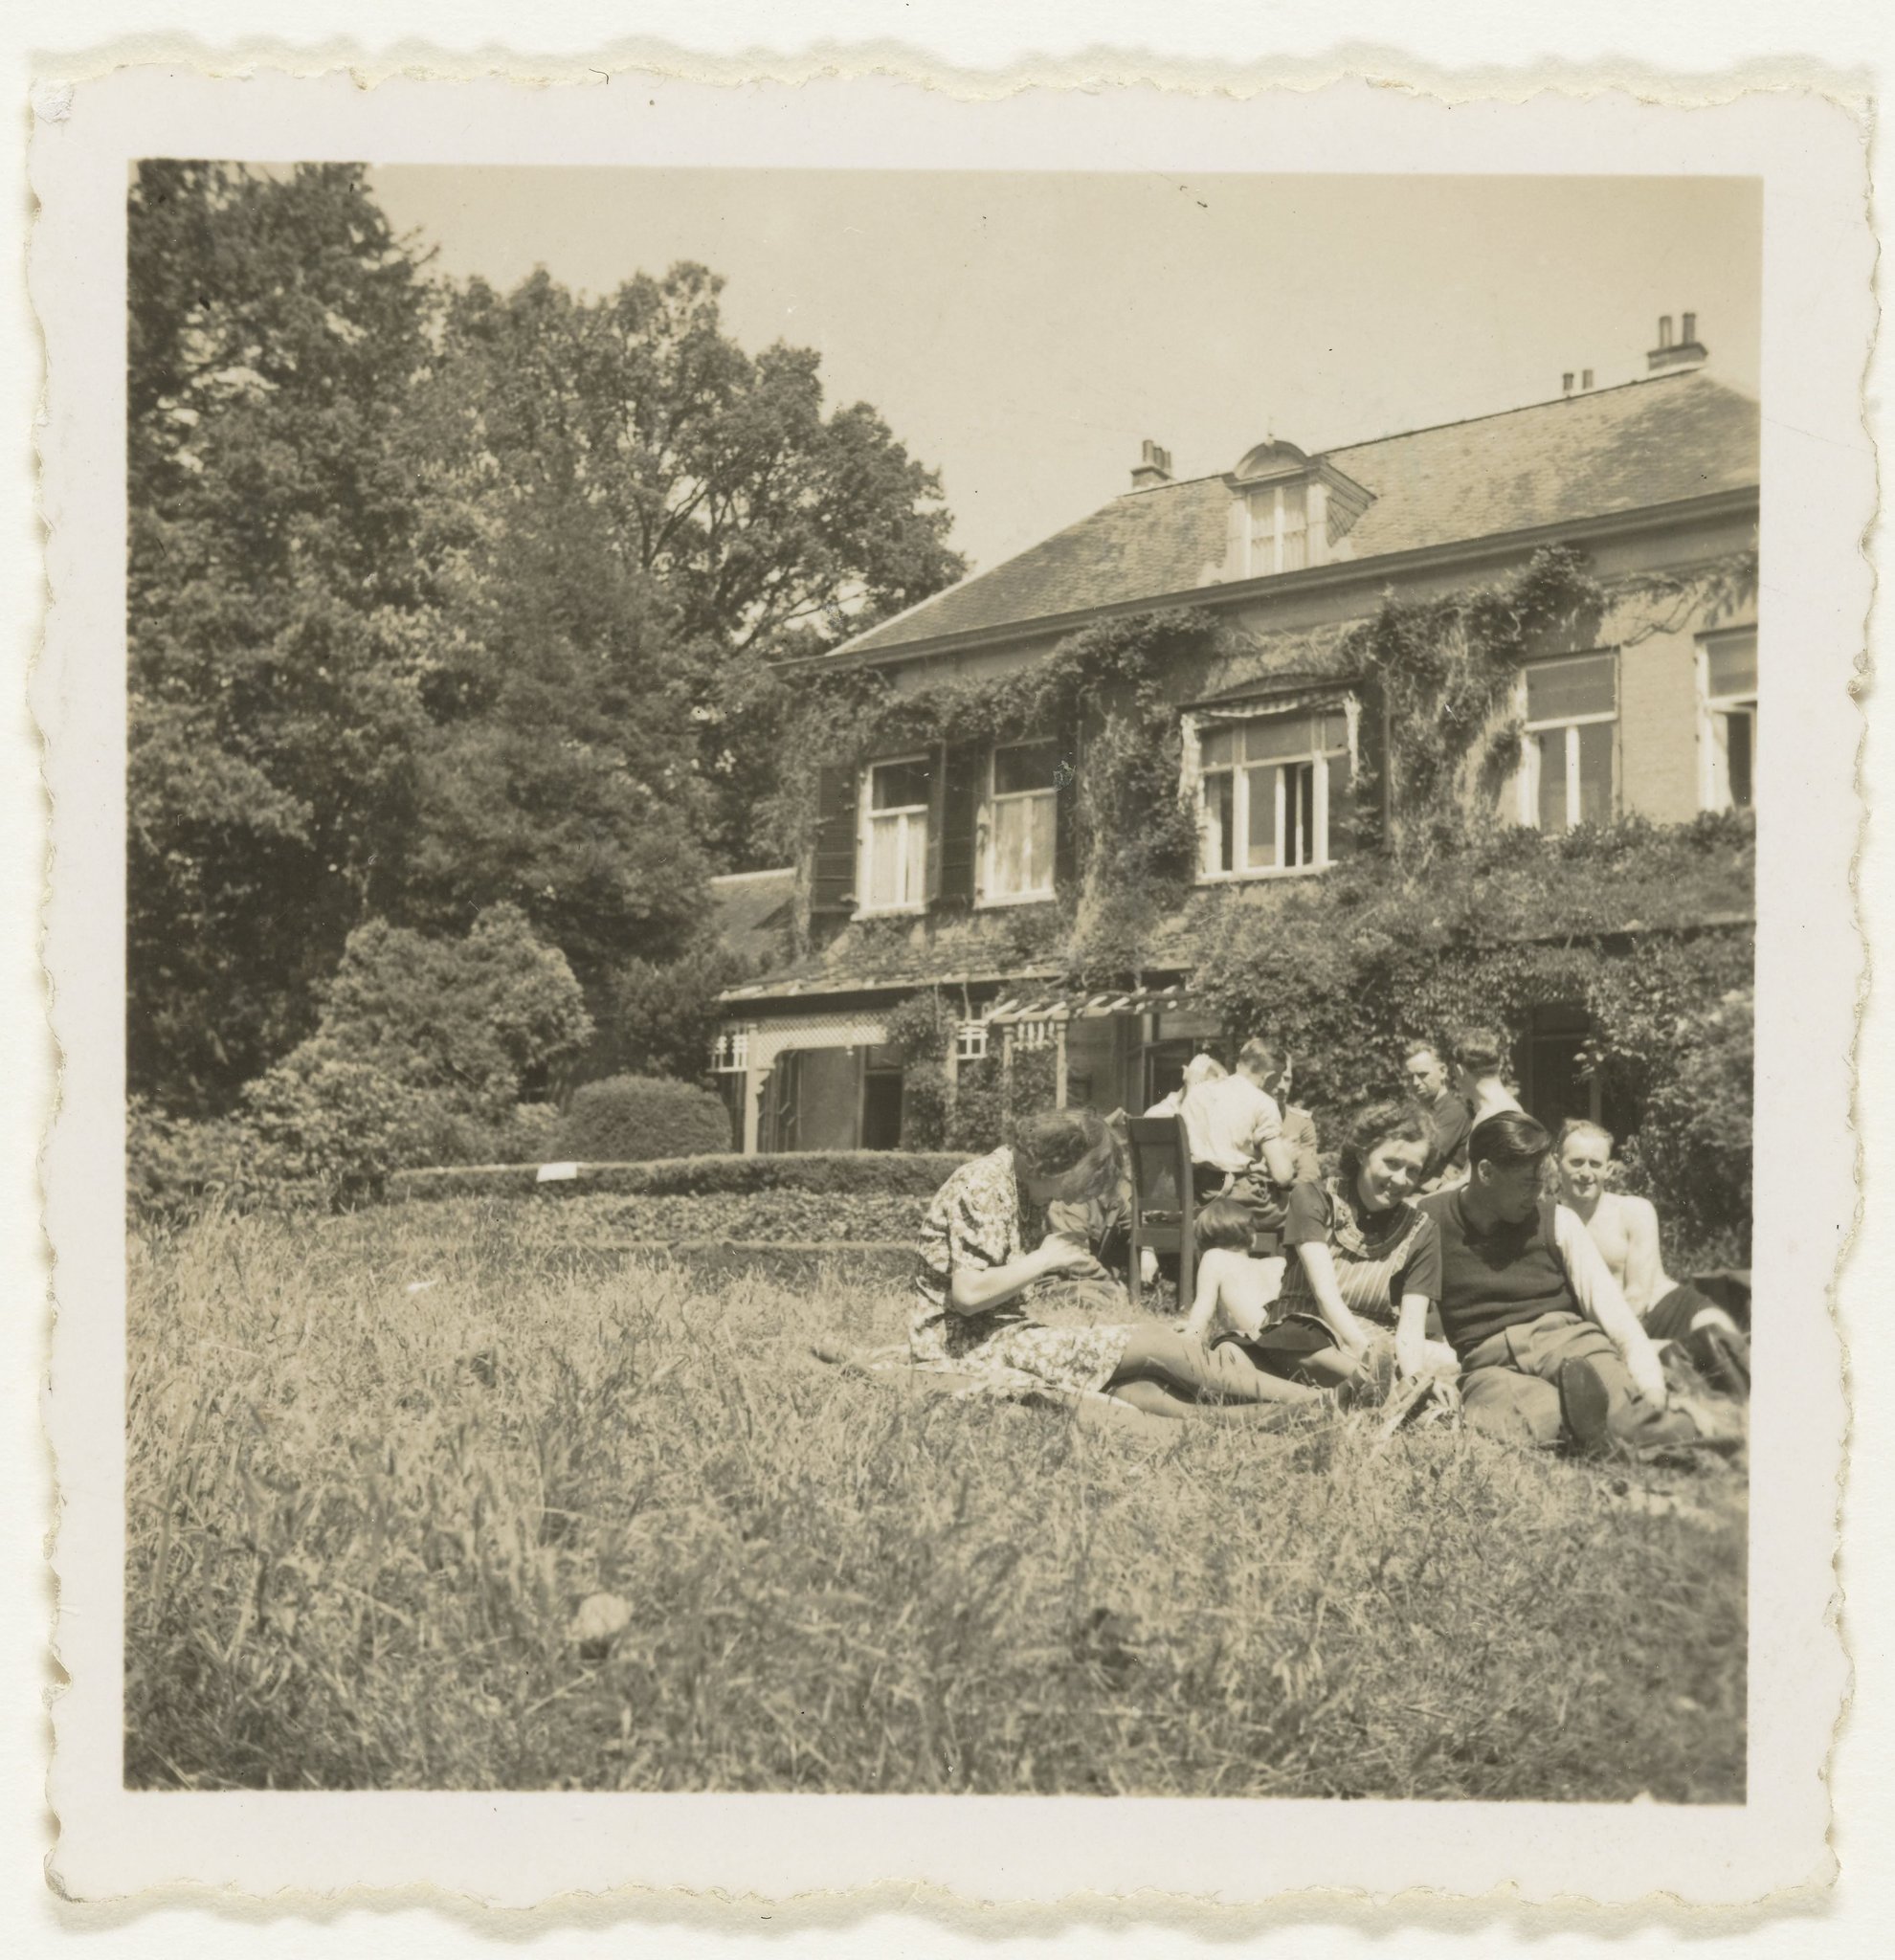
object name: photograph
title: Groep Nederlanders en Duitse militairen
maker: Anonymous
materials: photographic support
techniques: gelatin silver print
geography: netherlands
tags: occupier and civilians, occupation ~ war, netherlands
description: Een groep Nederlanders zitten in het gras voor een villa, achter hen aan een tafel zitten Duitse militairen